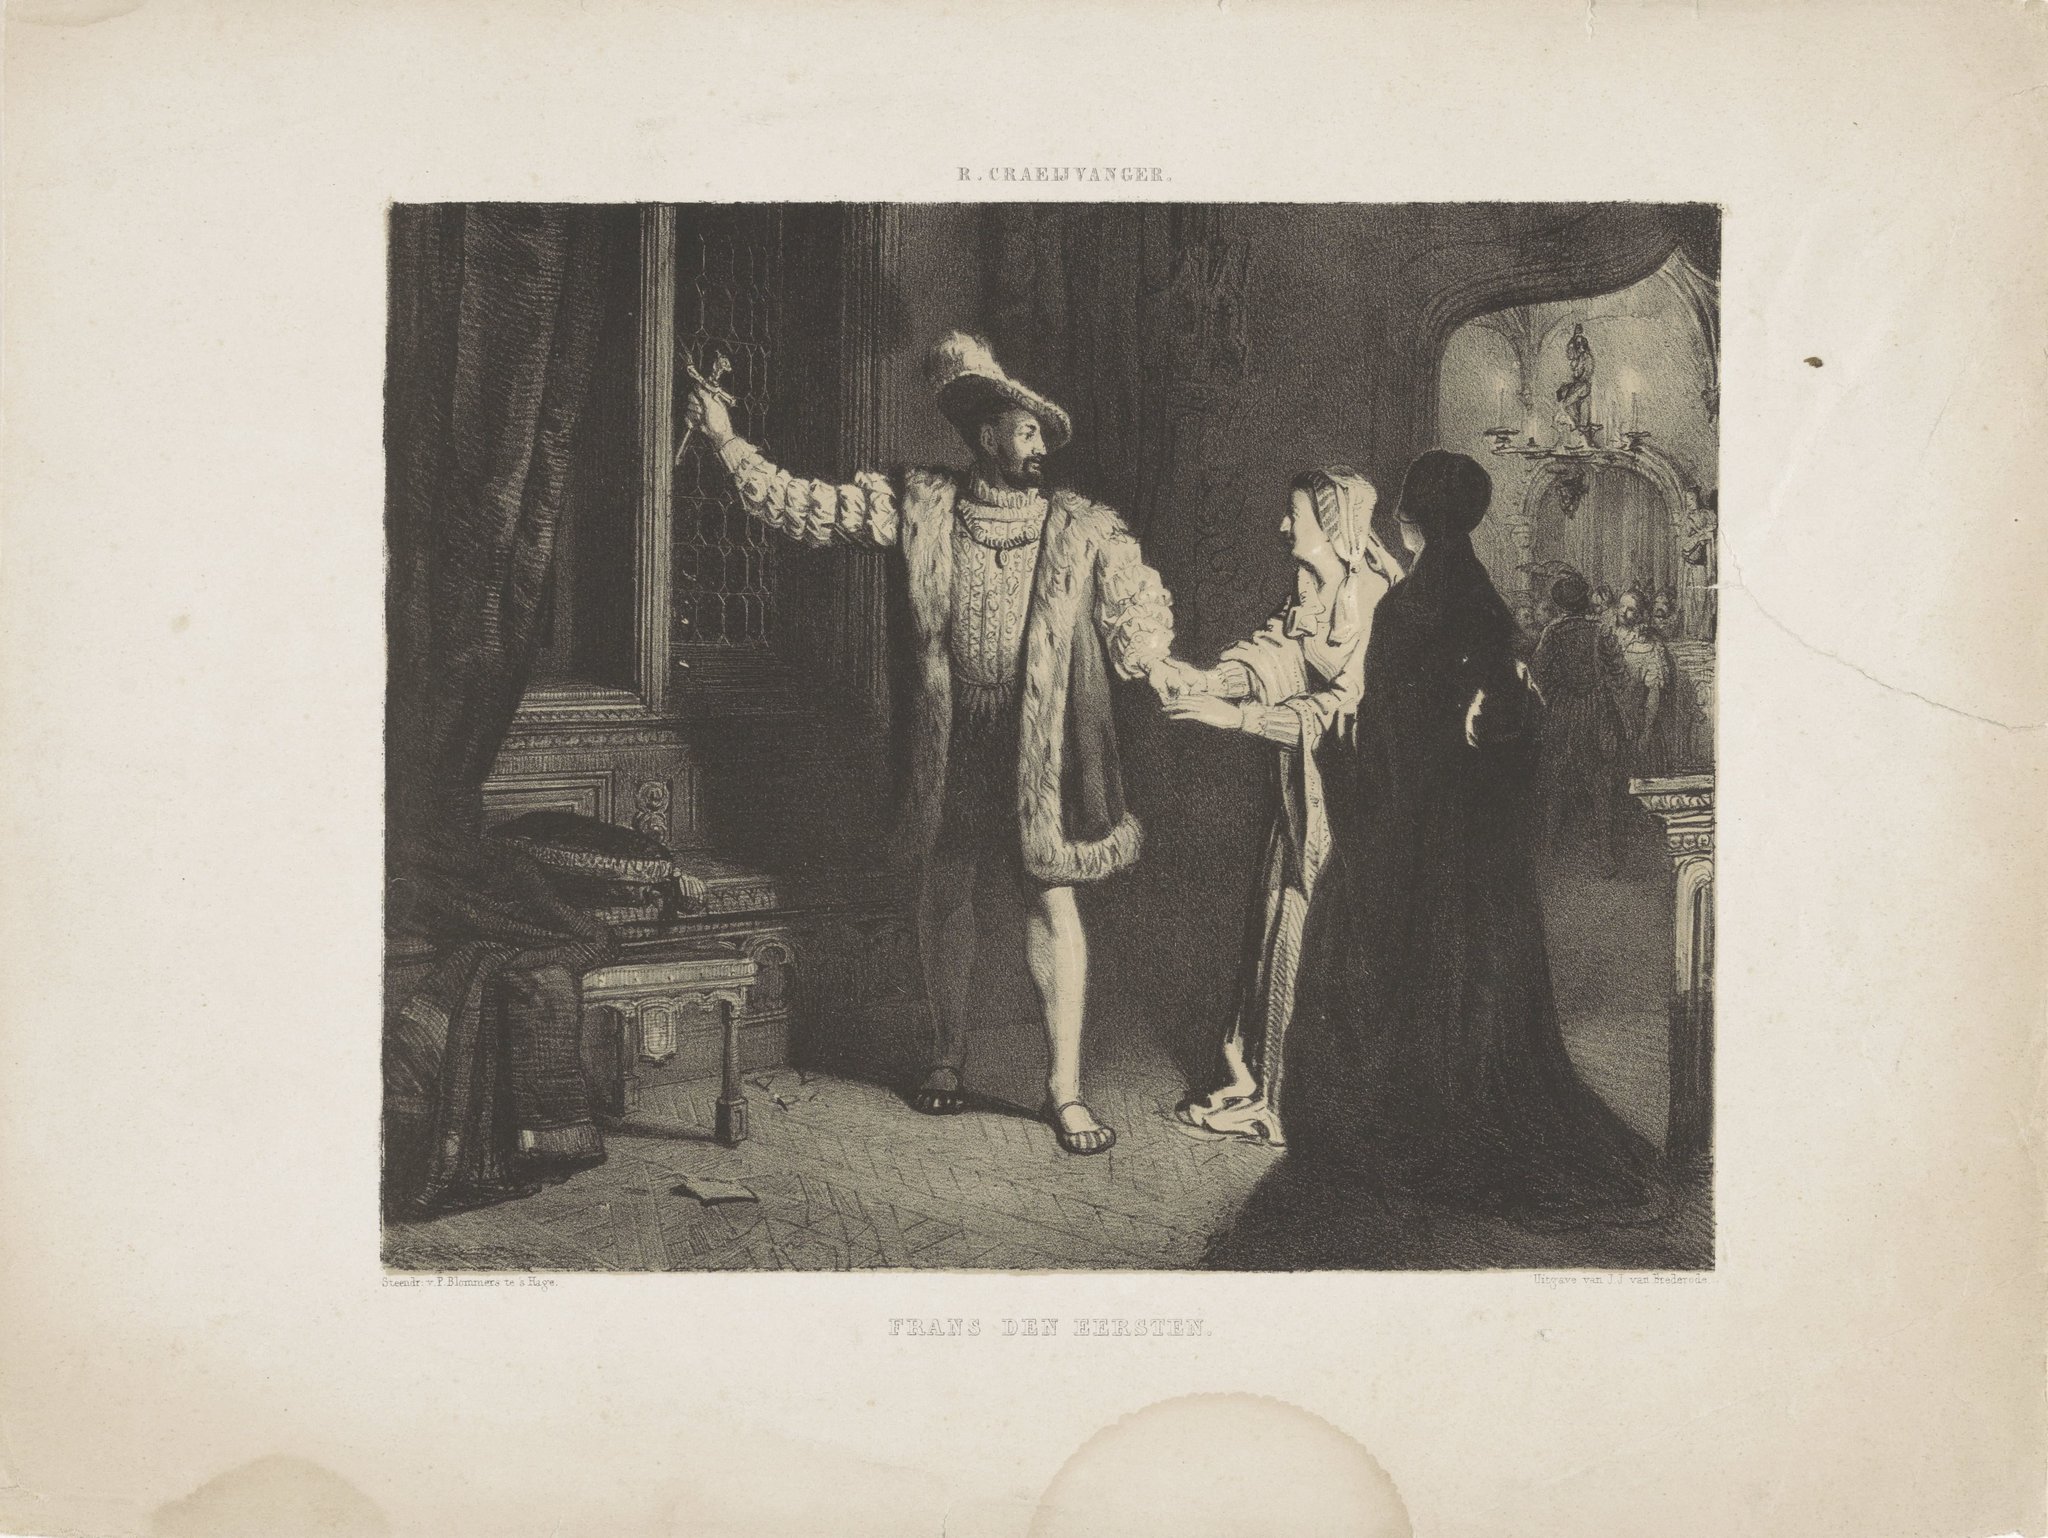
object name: print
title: Episode uit het leven van Frans I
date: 1847-1887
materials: paper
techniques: tone lithography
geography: haarlem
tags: frans i van valois-angoulême (koning van frankrijk), hacking and thrusting weapons: dagger, historical persons, open window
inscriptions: collector's mark: Lugt 2228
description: Scène uit het leven van koning Frans I van Frankrijk. De koning staat met twee dames bij een open raam. Zijn rechterhand, met daarin een dolk, houdt hij omhoog.